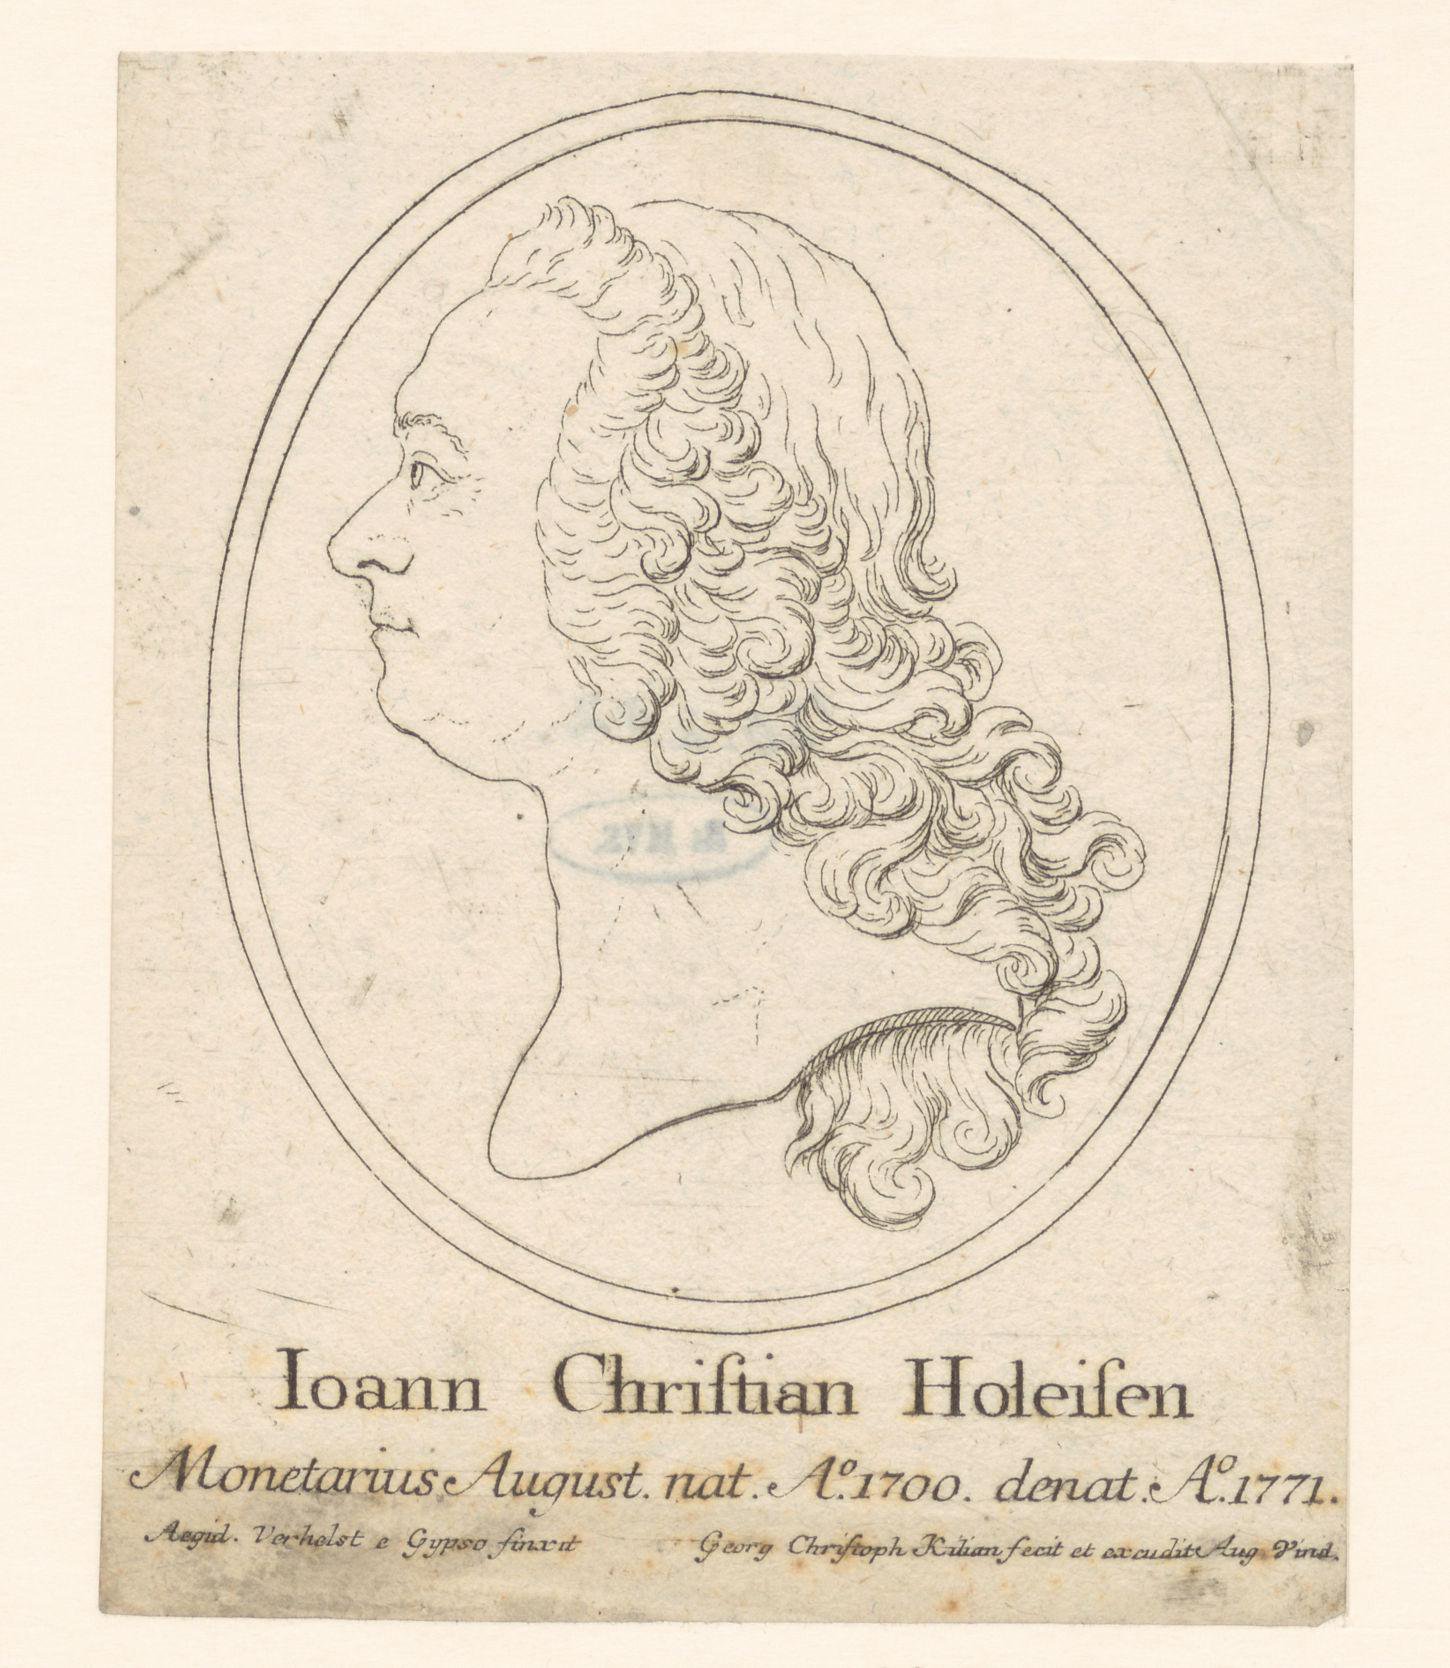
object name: print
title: Portret van Johann Christian Holeisen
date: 1771-1781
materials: paper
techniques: etching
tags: mintmaster, historical persons, dealing in money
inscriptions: collector's mark: Lugt 2228